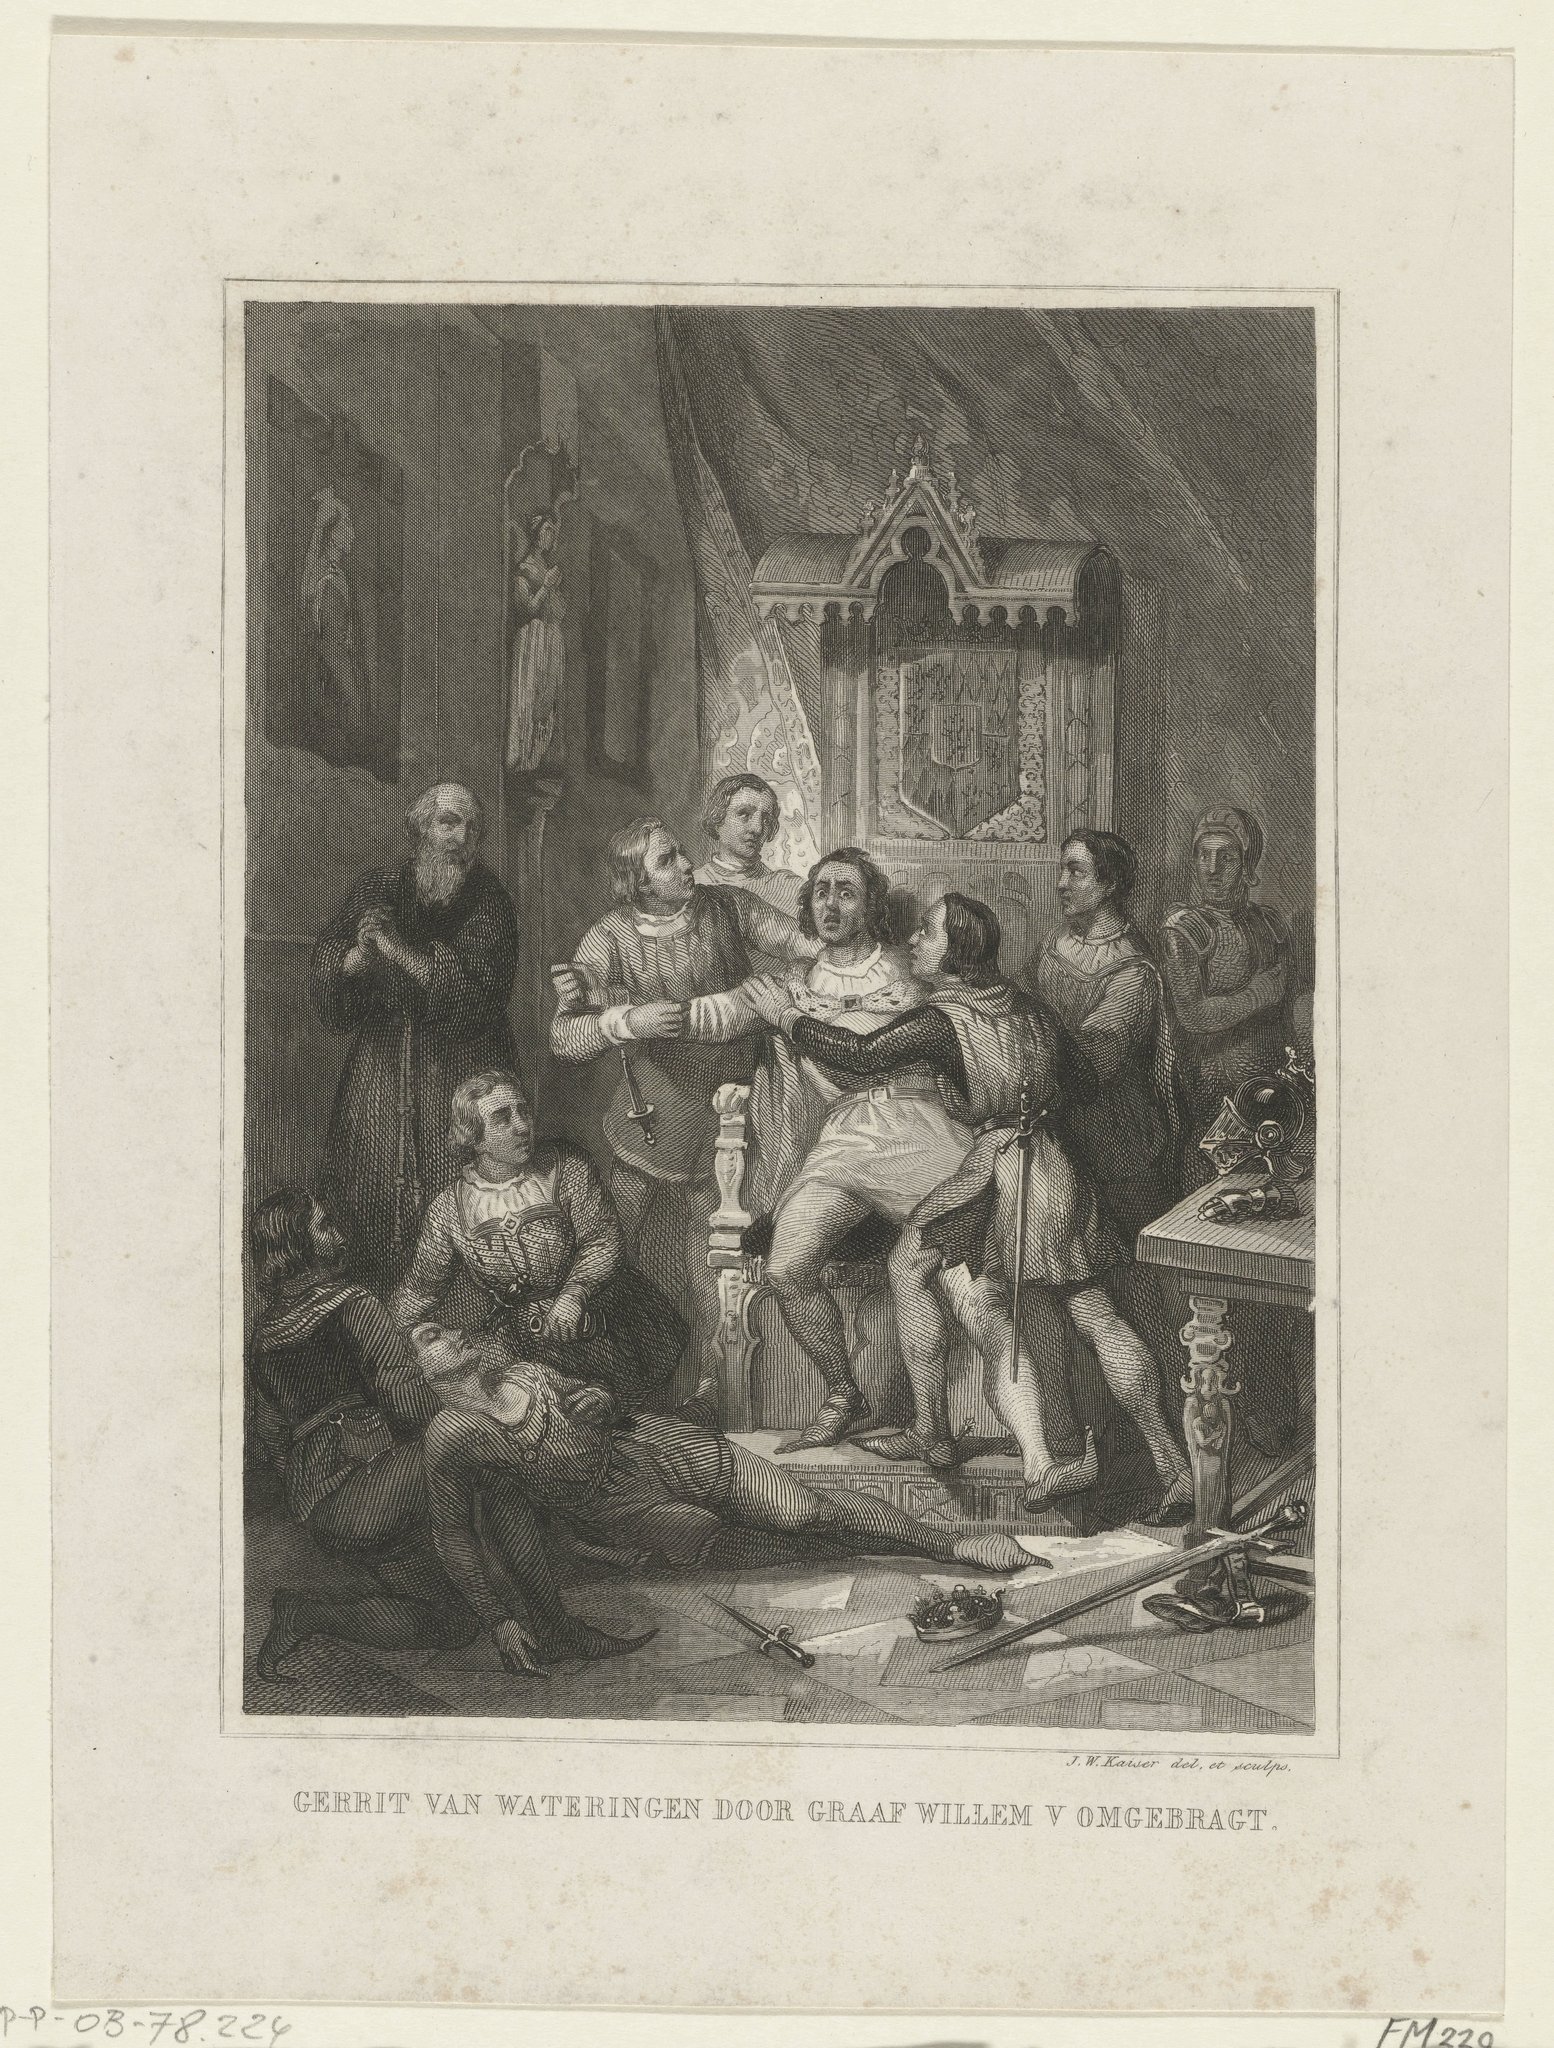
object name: print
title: Gerrit van Wateringen vermoord door graaf Willem V, ca. 1358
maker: johann wilhelm kaiser (i)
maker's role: draughtsman, print maker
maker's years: 1813-1900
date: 1842-1844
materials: paper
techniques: engraving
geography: netherlands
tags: earl, willem v van holland (graaf van holland en zeeland), violent death, being killed; being mishandled and maltreated; seeking death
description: Illustratie voor: J.P. Arend, Algemeene geschiedenis des vaderlands, Amsterdam, 5 delen, 1840-1882, dl. 2.2 (1844), p. 247.